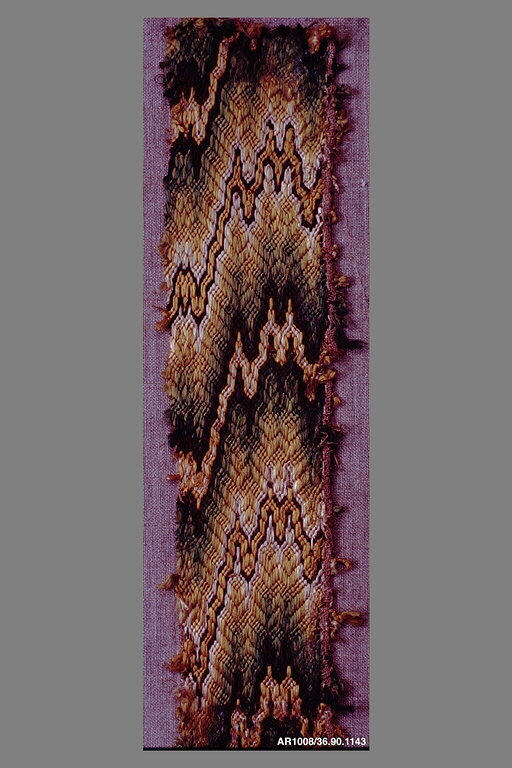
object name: piece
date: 1701-1800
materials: cotton, silk